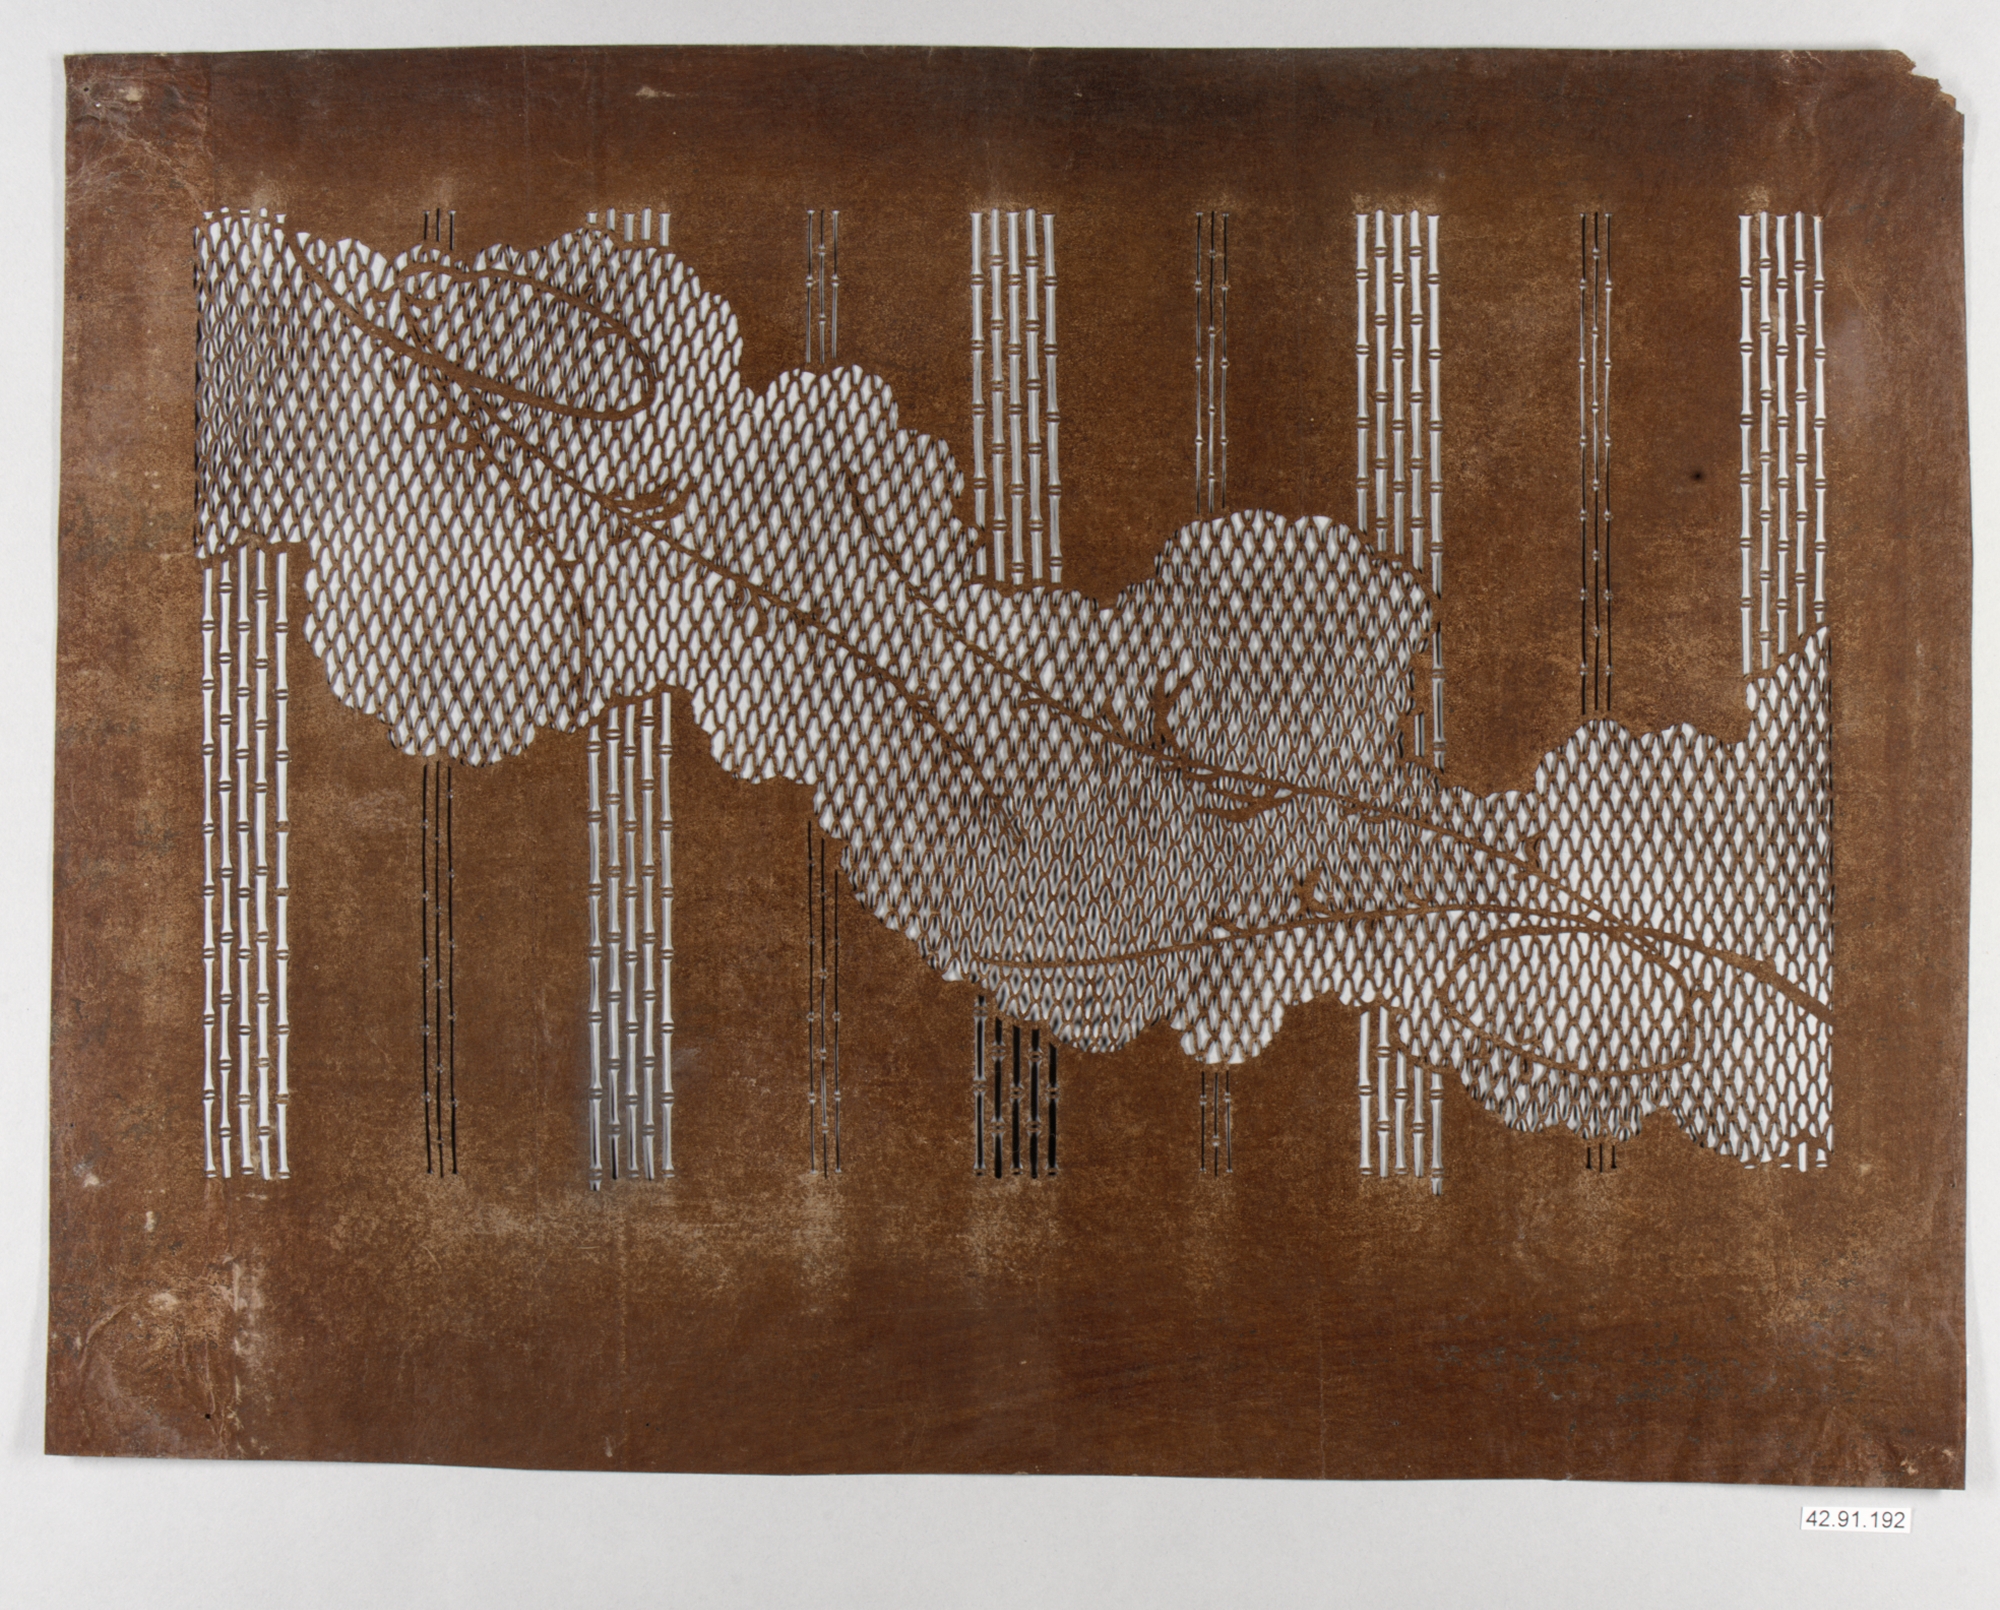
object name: stencil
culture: japanese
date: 1801-1900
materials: paper